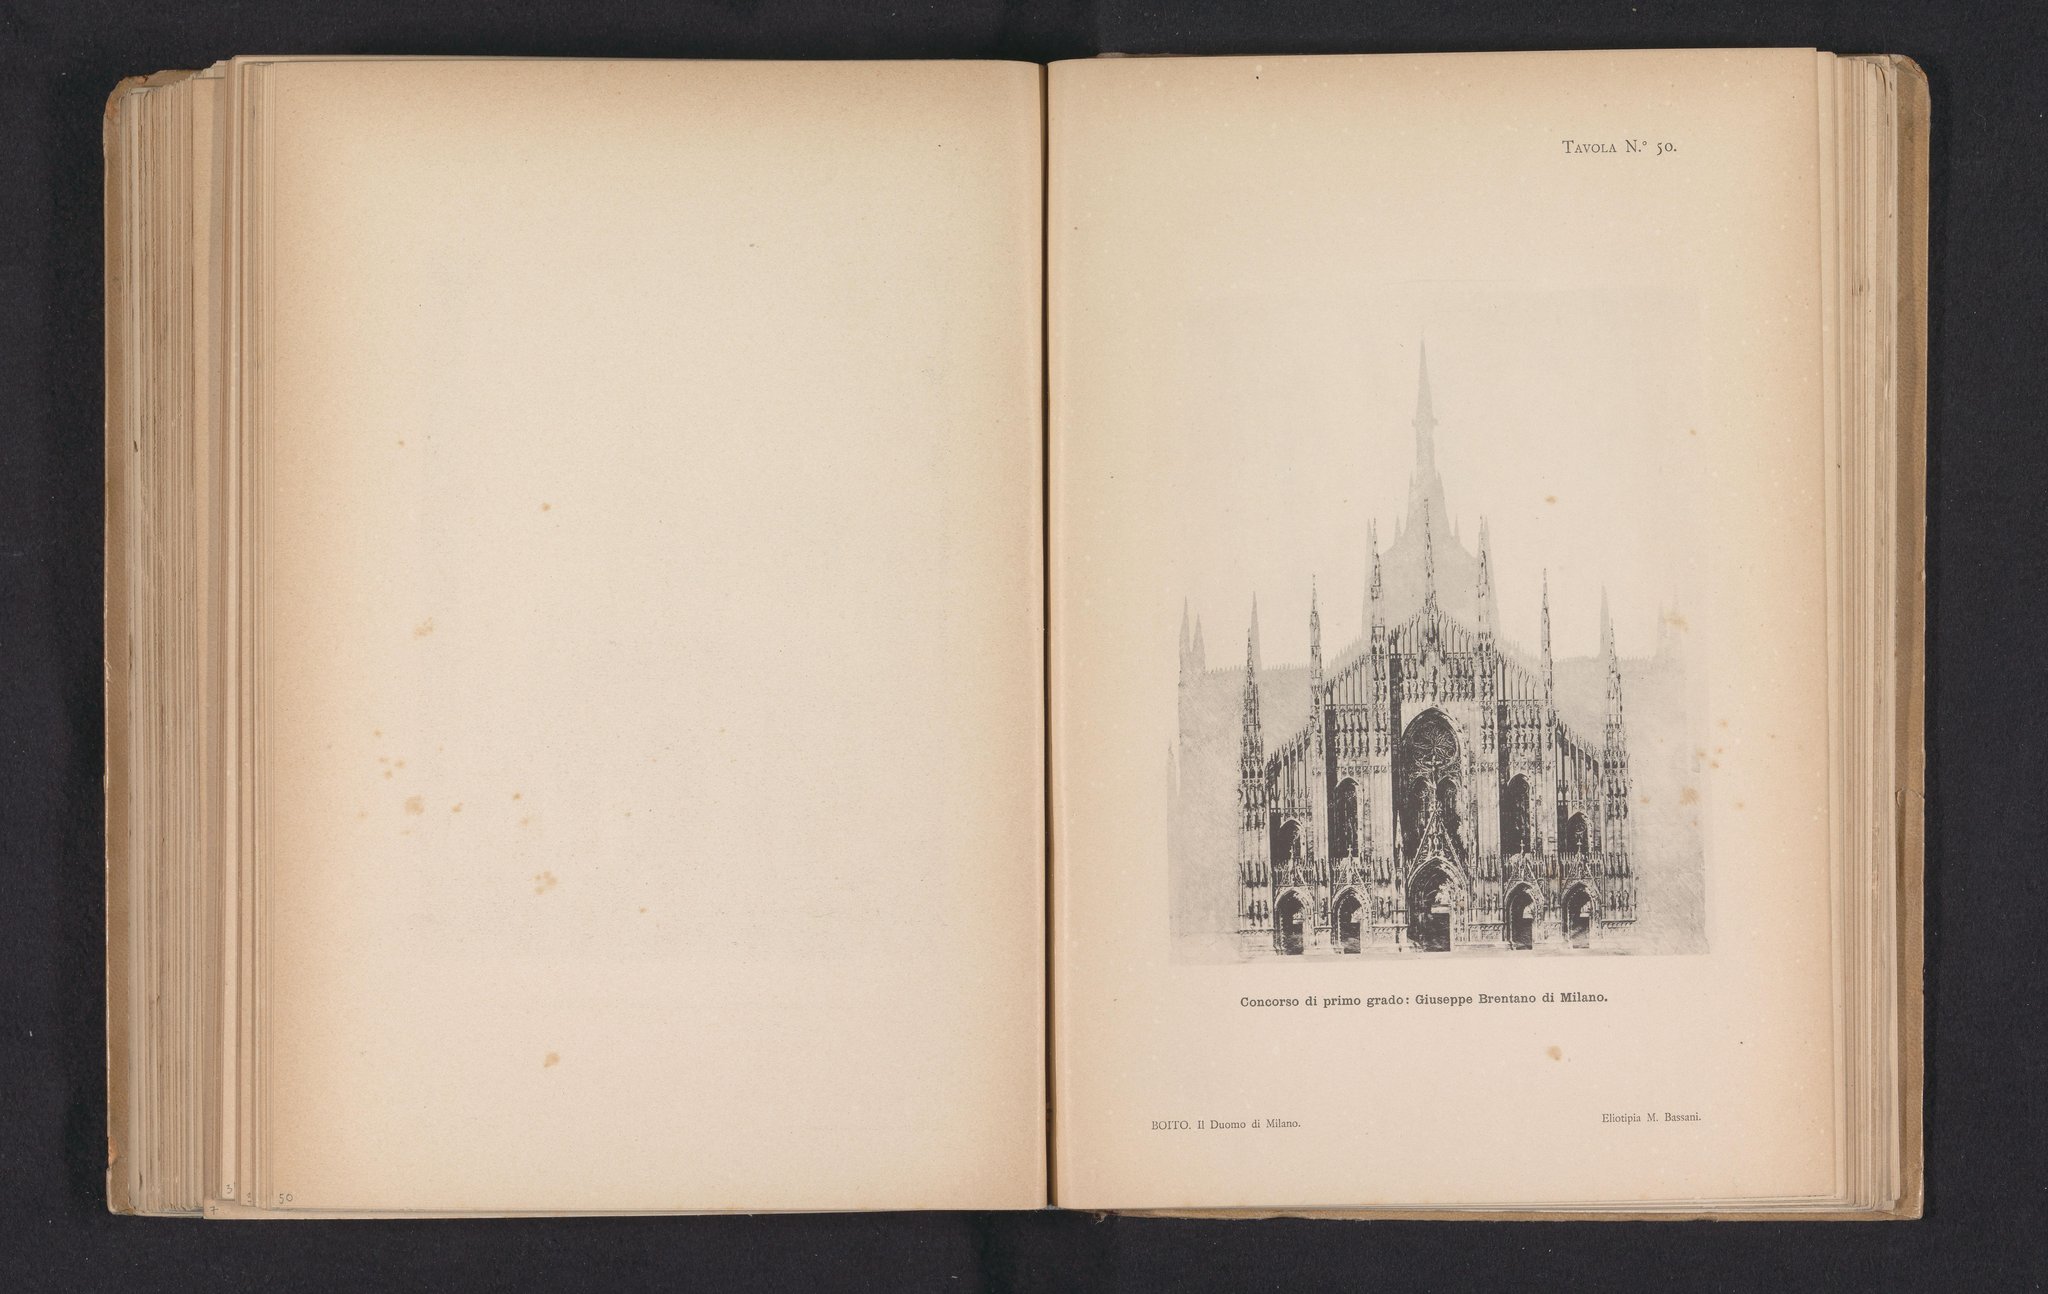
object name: reproduction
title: Concorso di primo grado : Giuseppe Brentano di Milano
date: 1886-1889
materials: paper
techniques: photograph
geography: milan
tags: drawing, sketch, parts of church exterior and annexes: façade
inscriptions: number: ‘Tavola No. 50.’